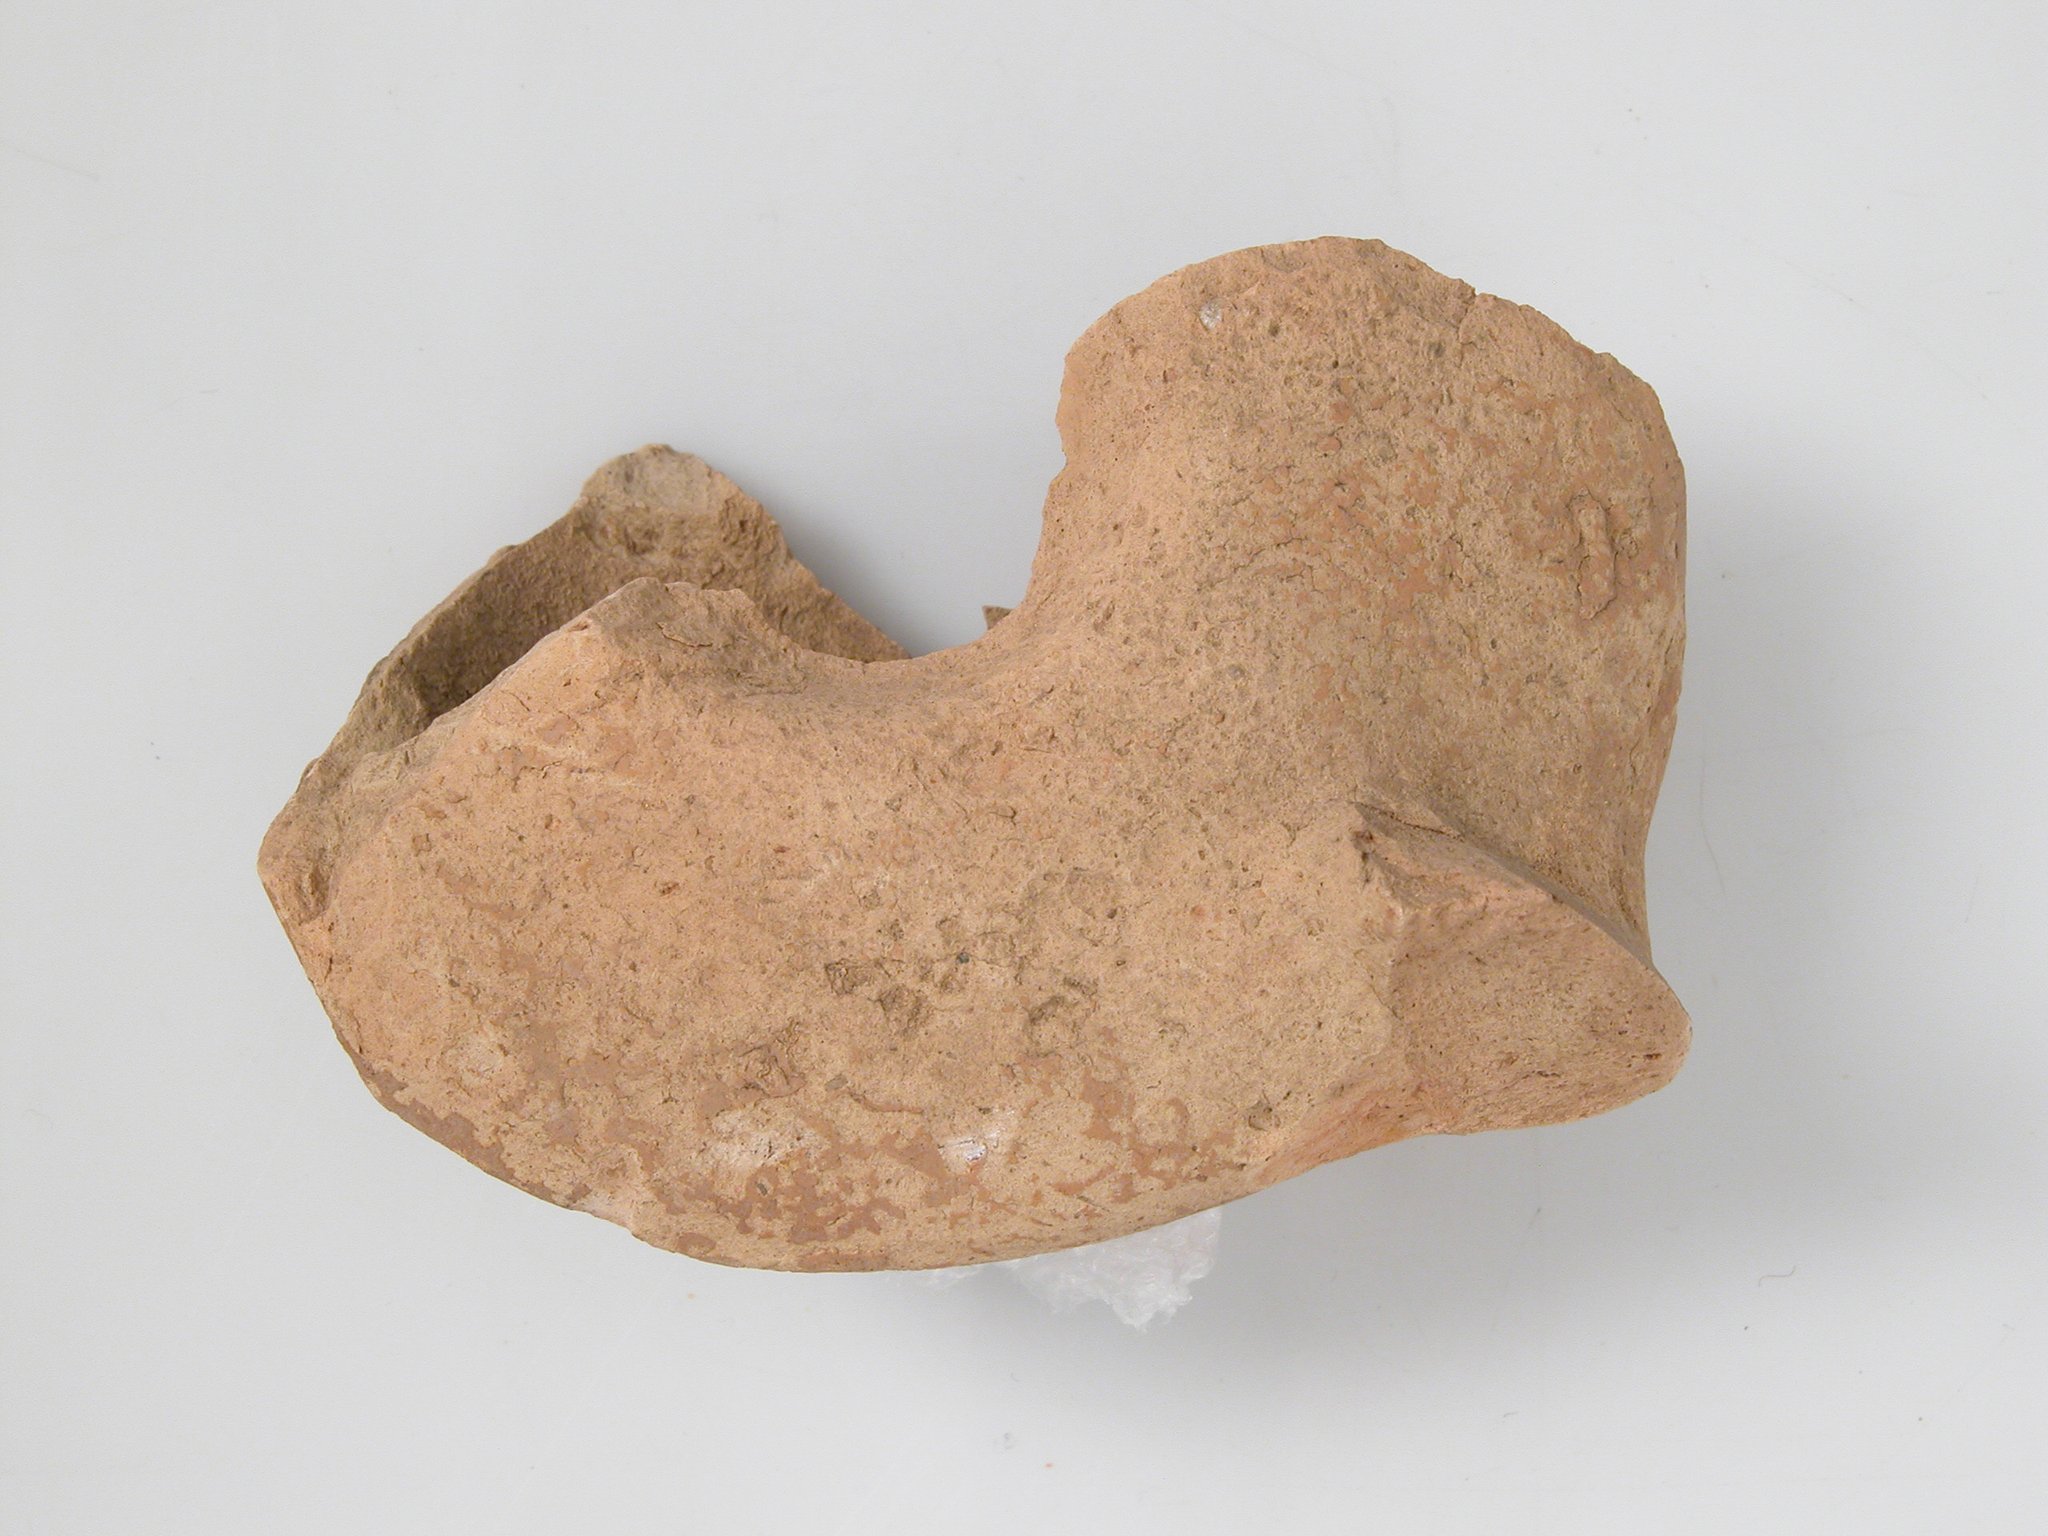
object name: fragment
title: Oil Lamp Fragment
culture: coptic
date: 301-700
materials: earthenware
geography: egypt